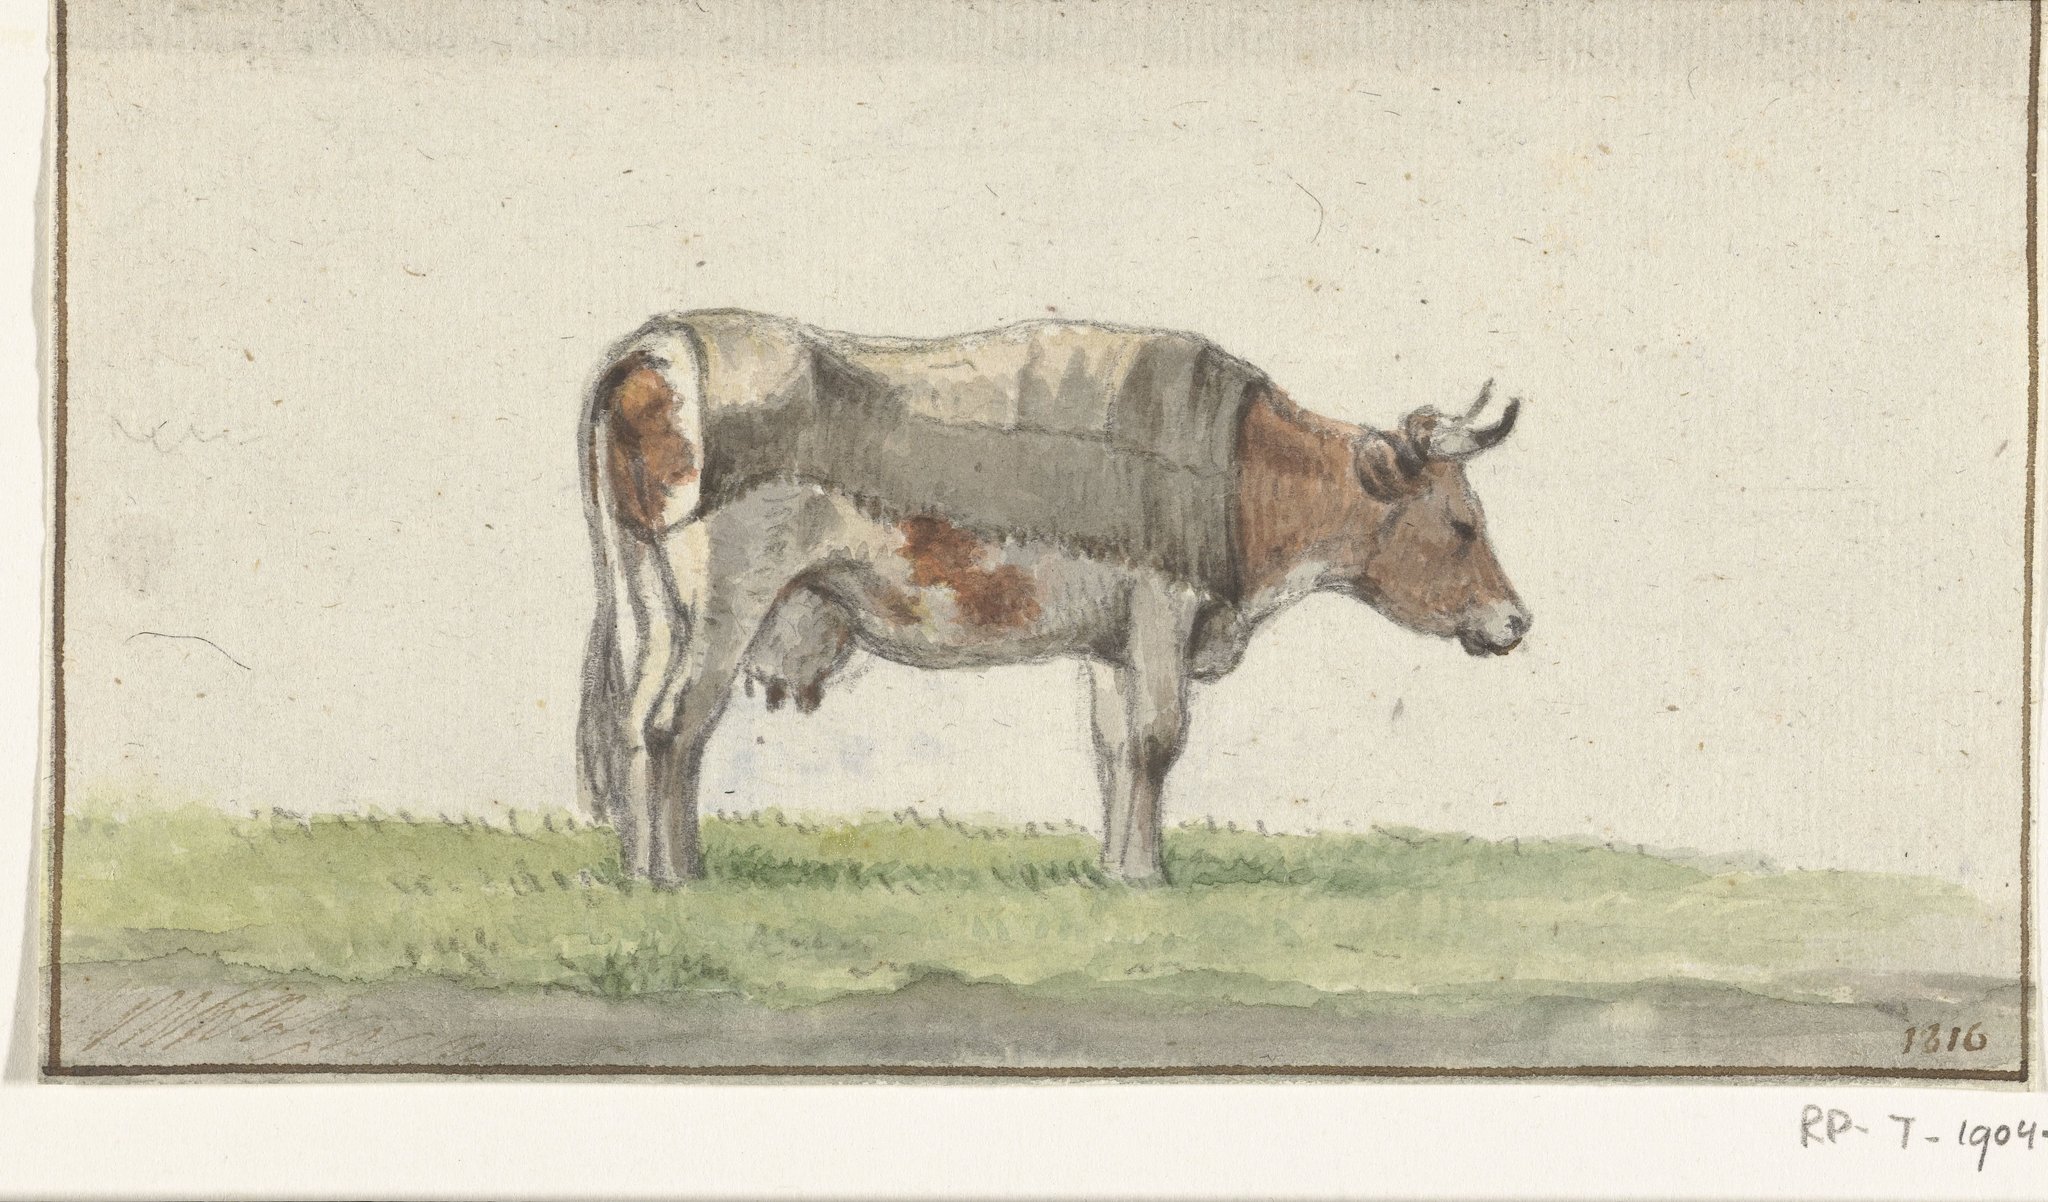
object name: watercolor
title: Staande koe, naar rechts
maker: jean bernard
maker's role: draughtsman, print maker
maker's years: 1765-1833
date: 1816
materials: chalk, paper, pencil, watercolor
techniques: brush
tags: cow